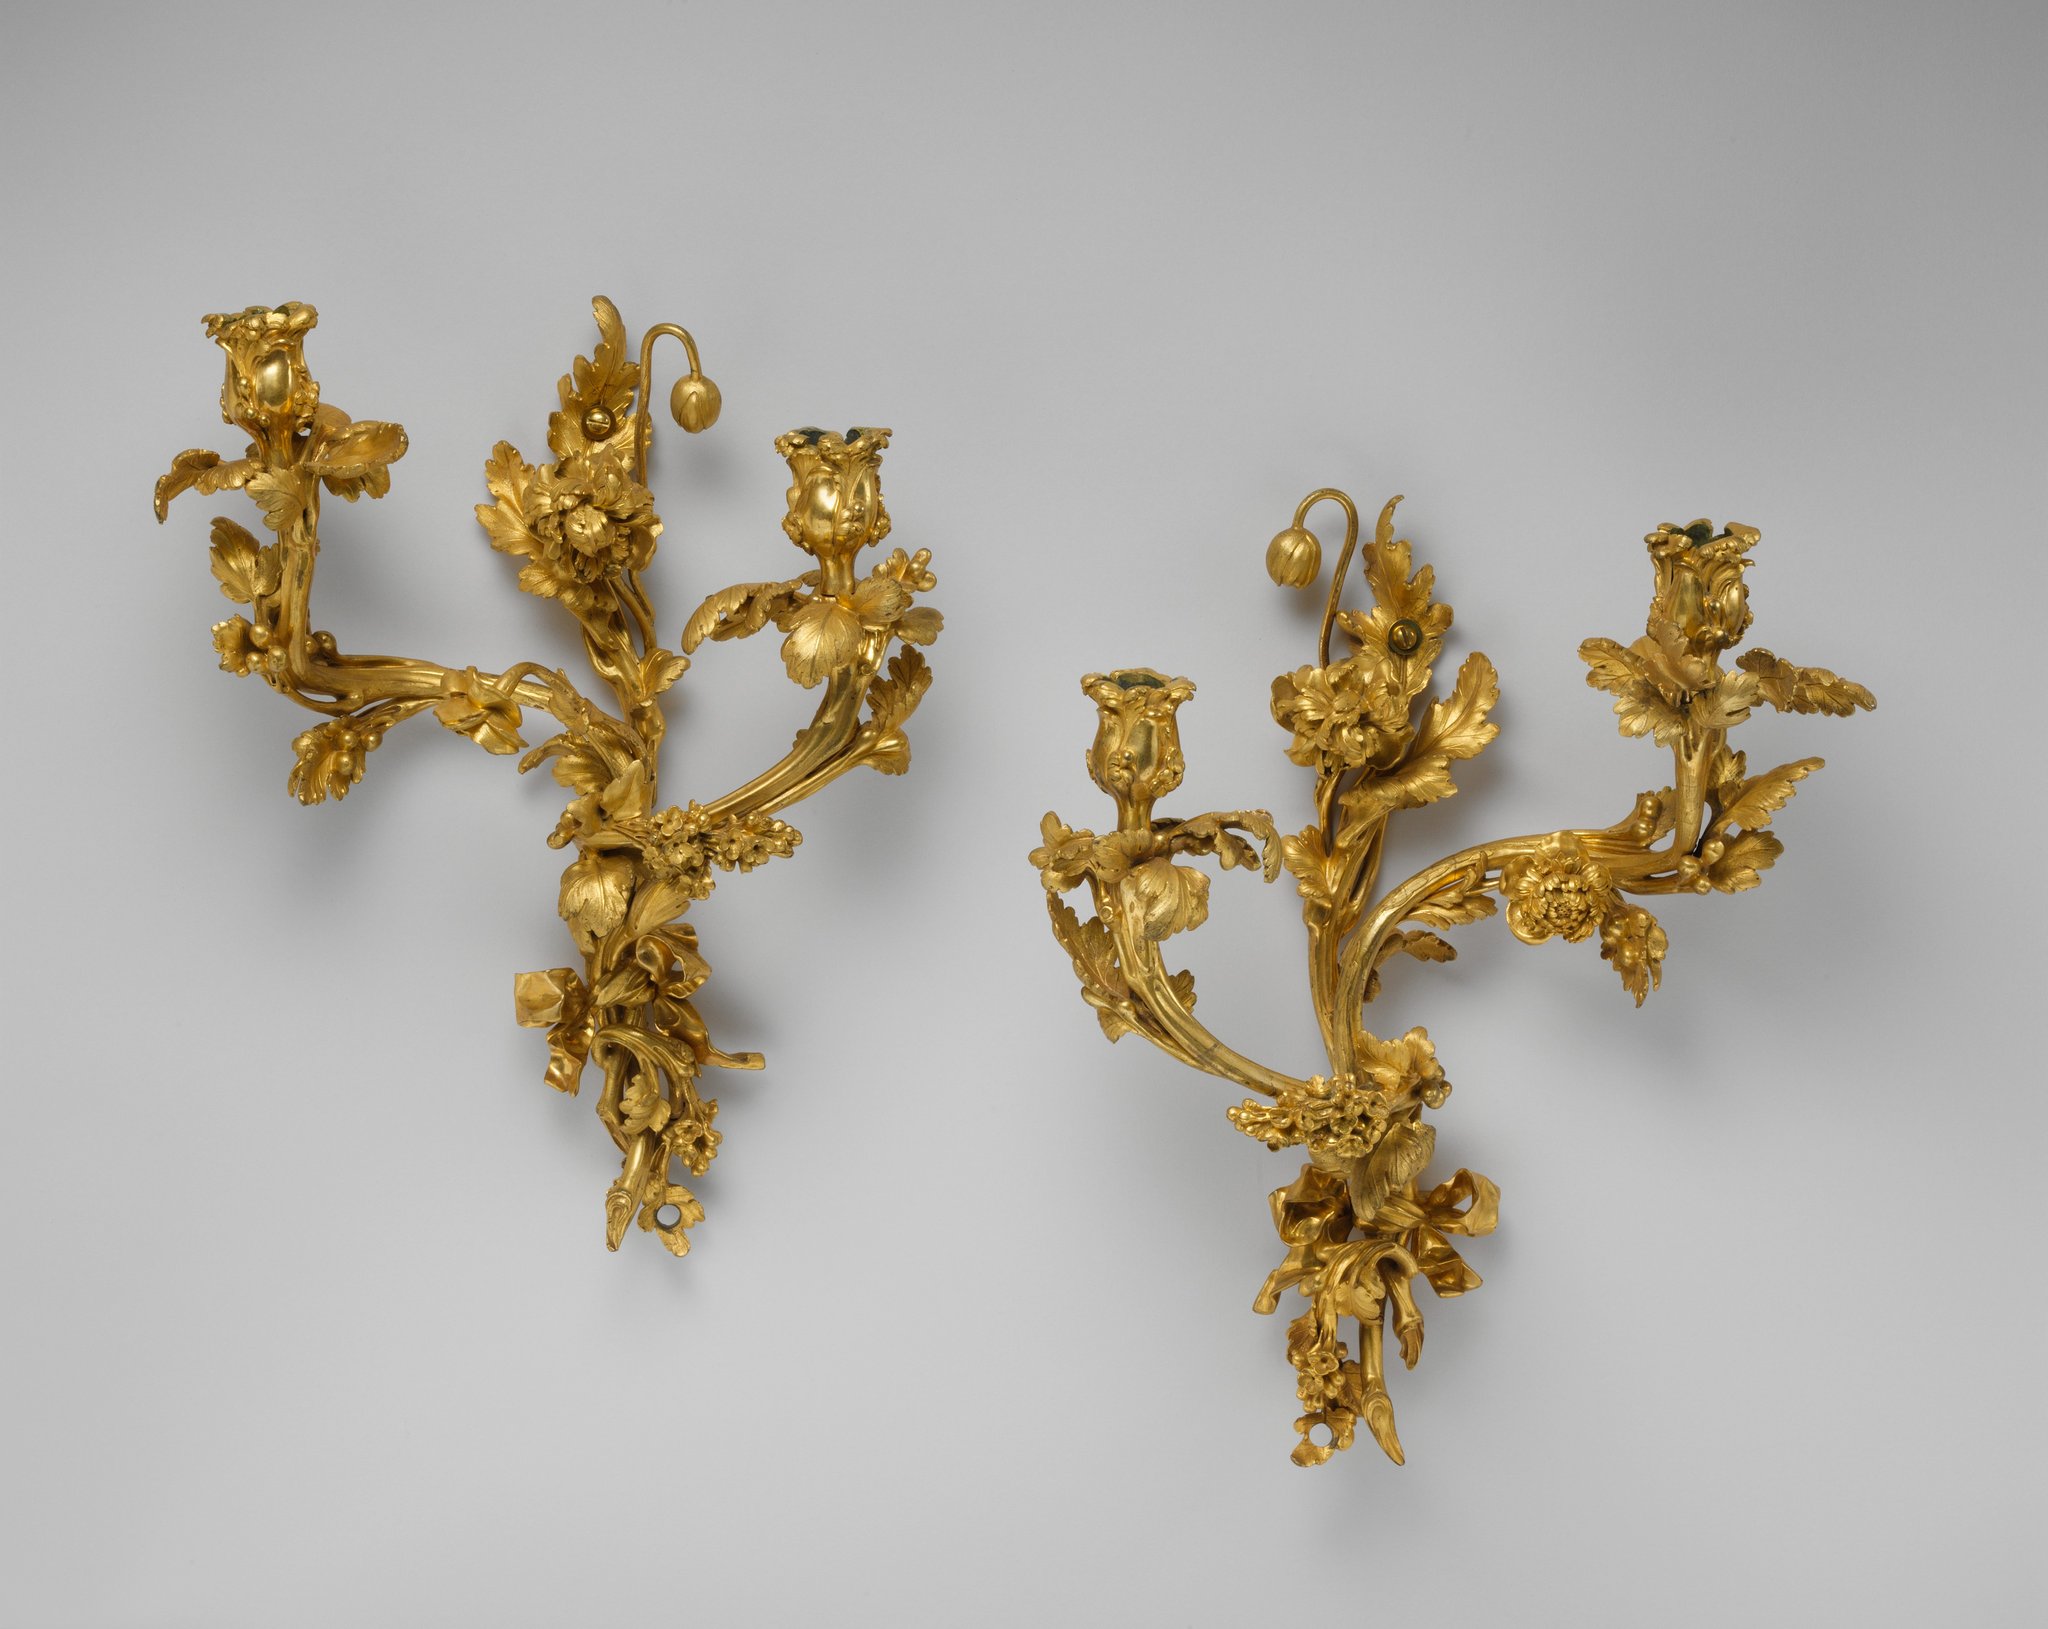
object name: wall bracket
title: Pair of two-light wall brackets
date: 1750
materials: gilt bronze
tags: flowers